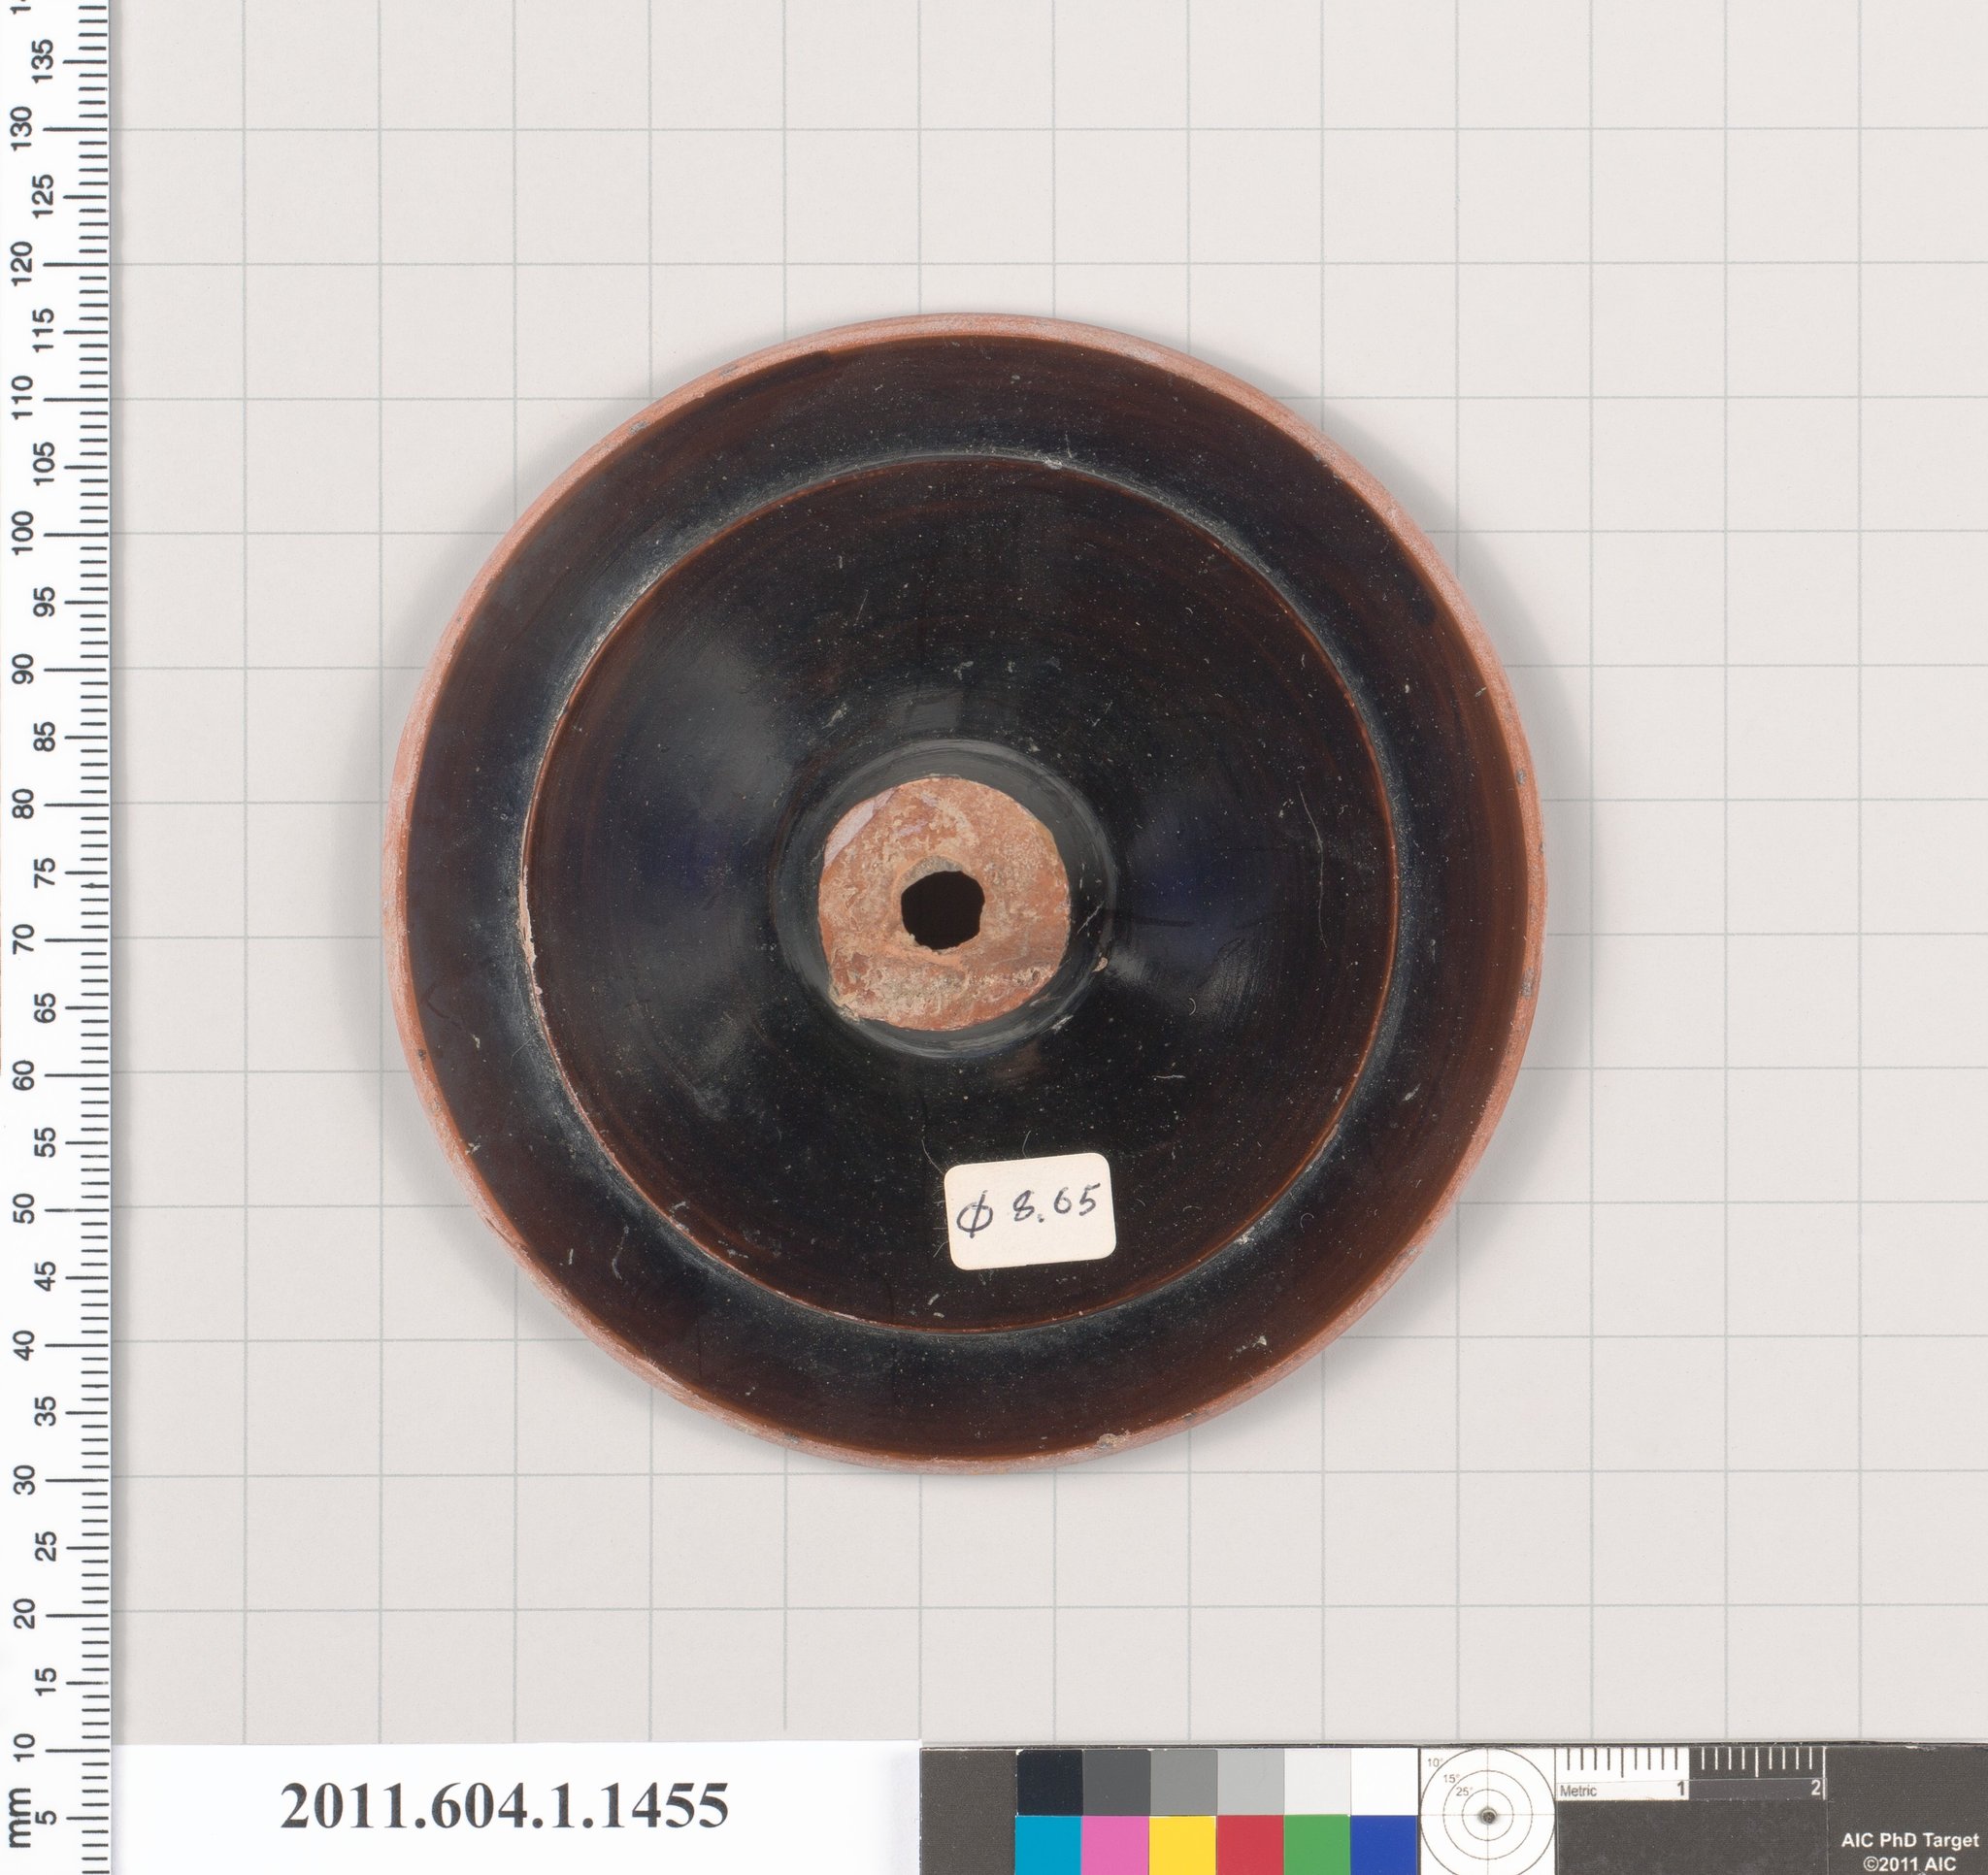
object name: kylix fragment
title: Terracotta fragment of a kylix (drinking cup)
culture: greek, attic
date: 500-401 BCE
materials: terracotta